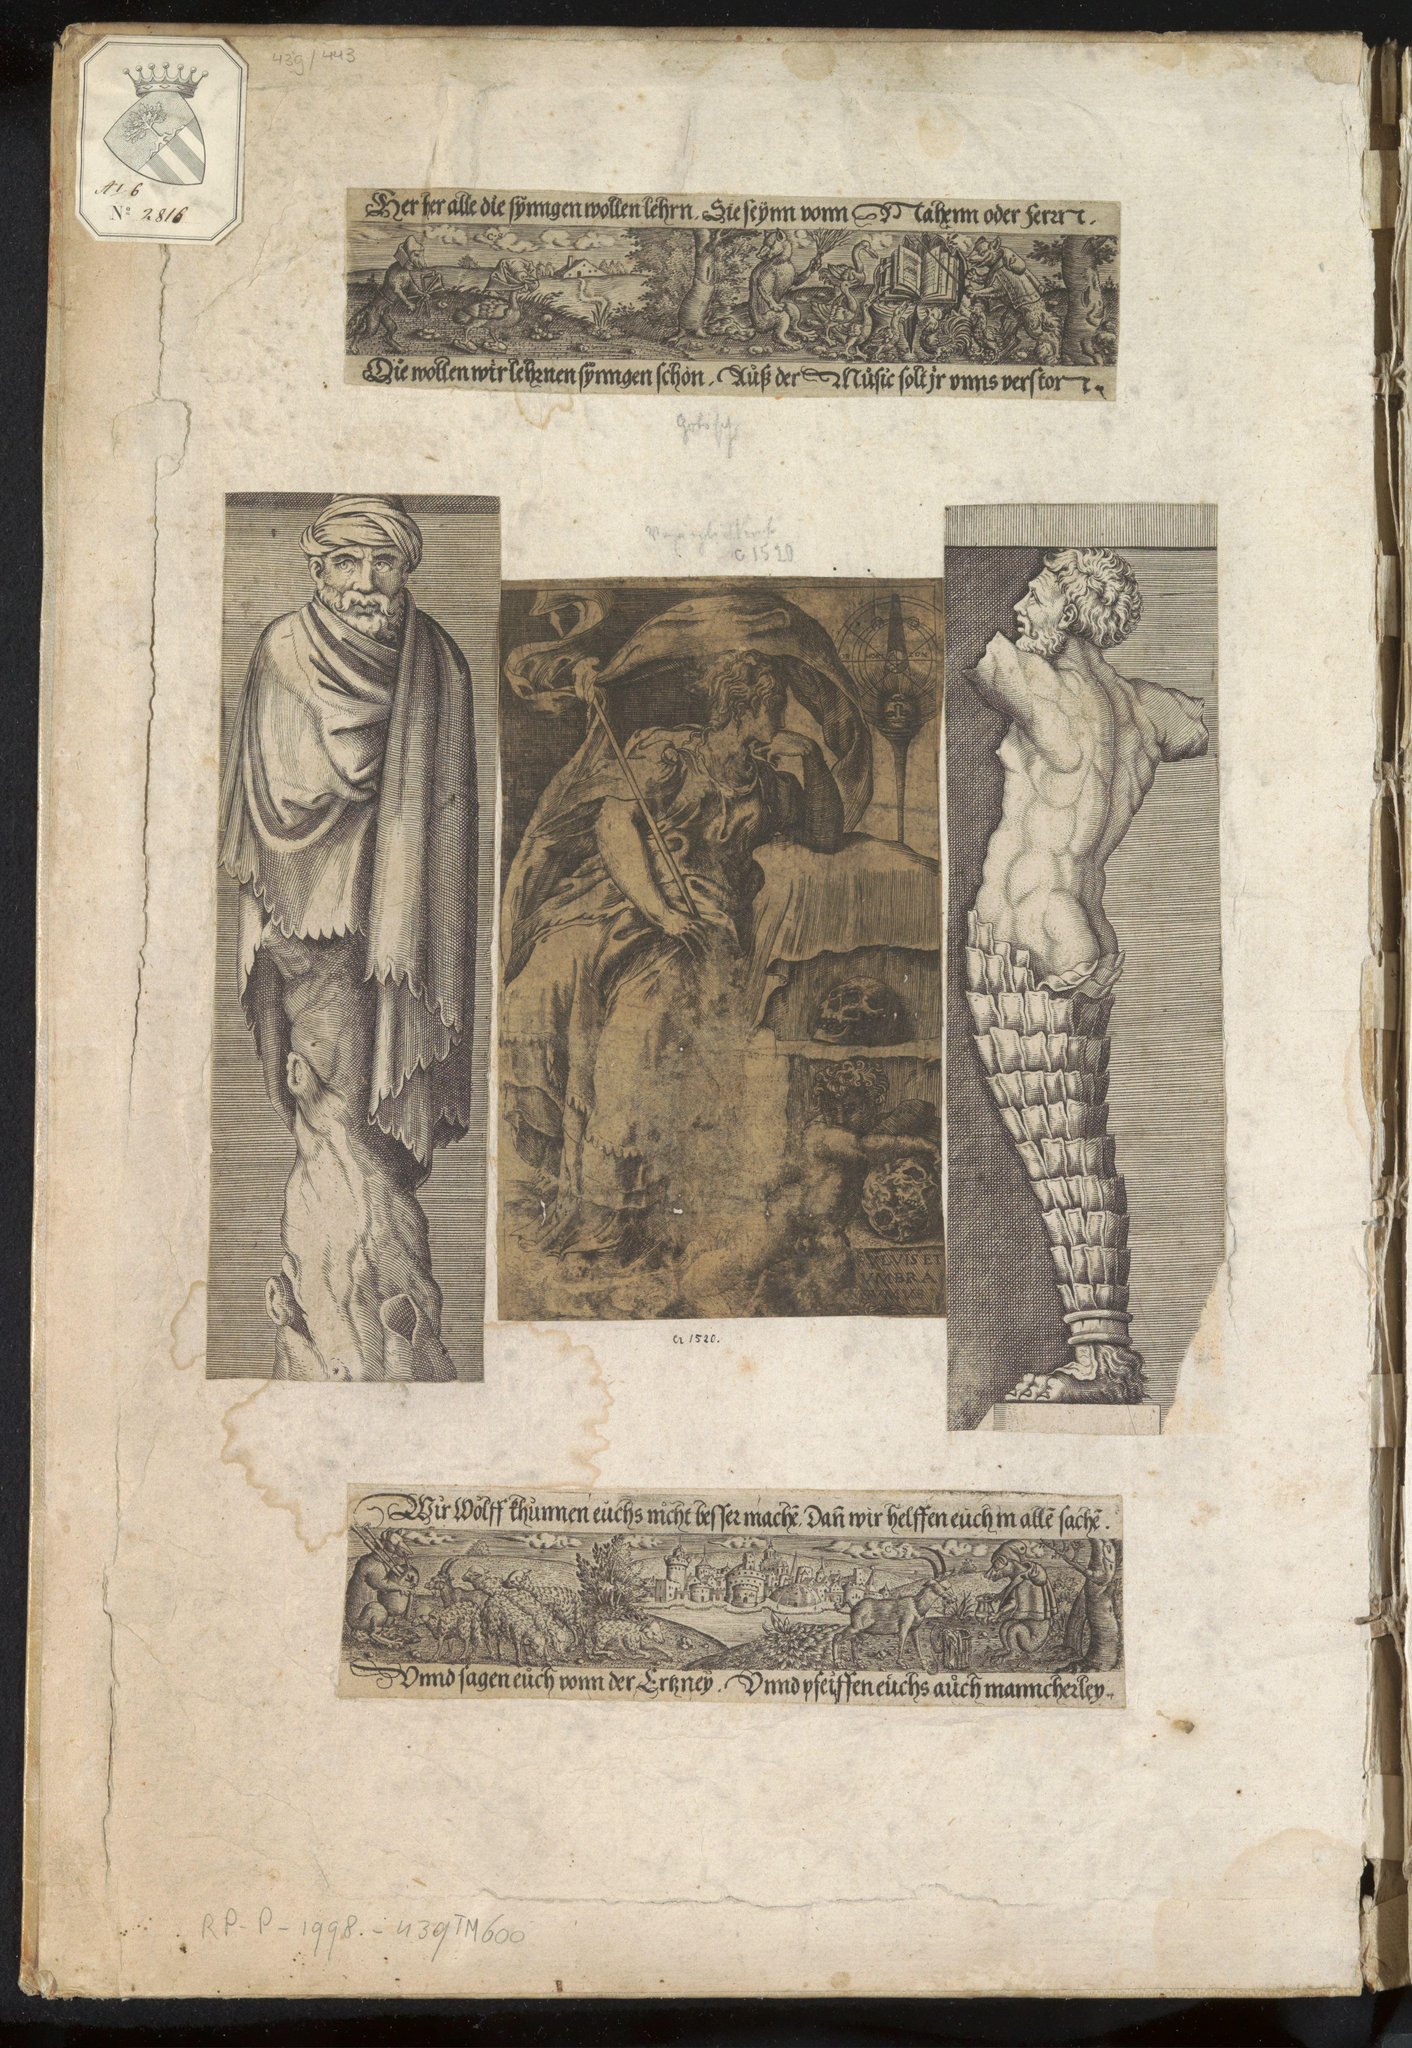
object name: album leaf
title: Albumblad met vijf prenten met fabelen, een vrouw met een vaandel en mannelijke hermen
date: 1500-1536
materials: paper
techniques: engraving, etching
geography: germany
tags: trees: palm-tree (+ stem, trunk), constructive (architectural) parts ~ human beings, trees (+ stem, trunk), fables, cupids: 'amores', 'amoretti', 'putti'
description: Albumblad met vijf uitgeknipte prenten: twee mannelijke hermen, twee verbeeldingen van fabelen en een vrouw met een vaandel.